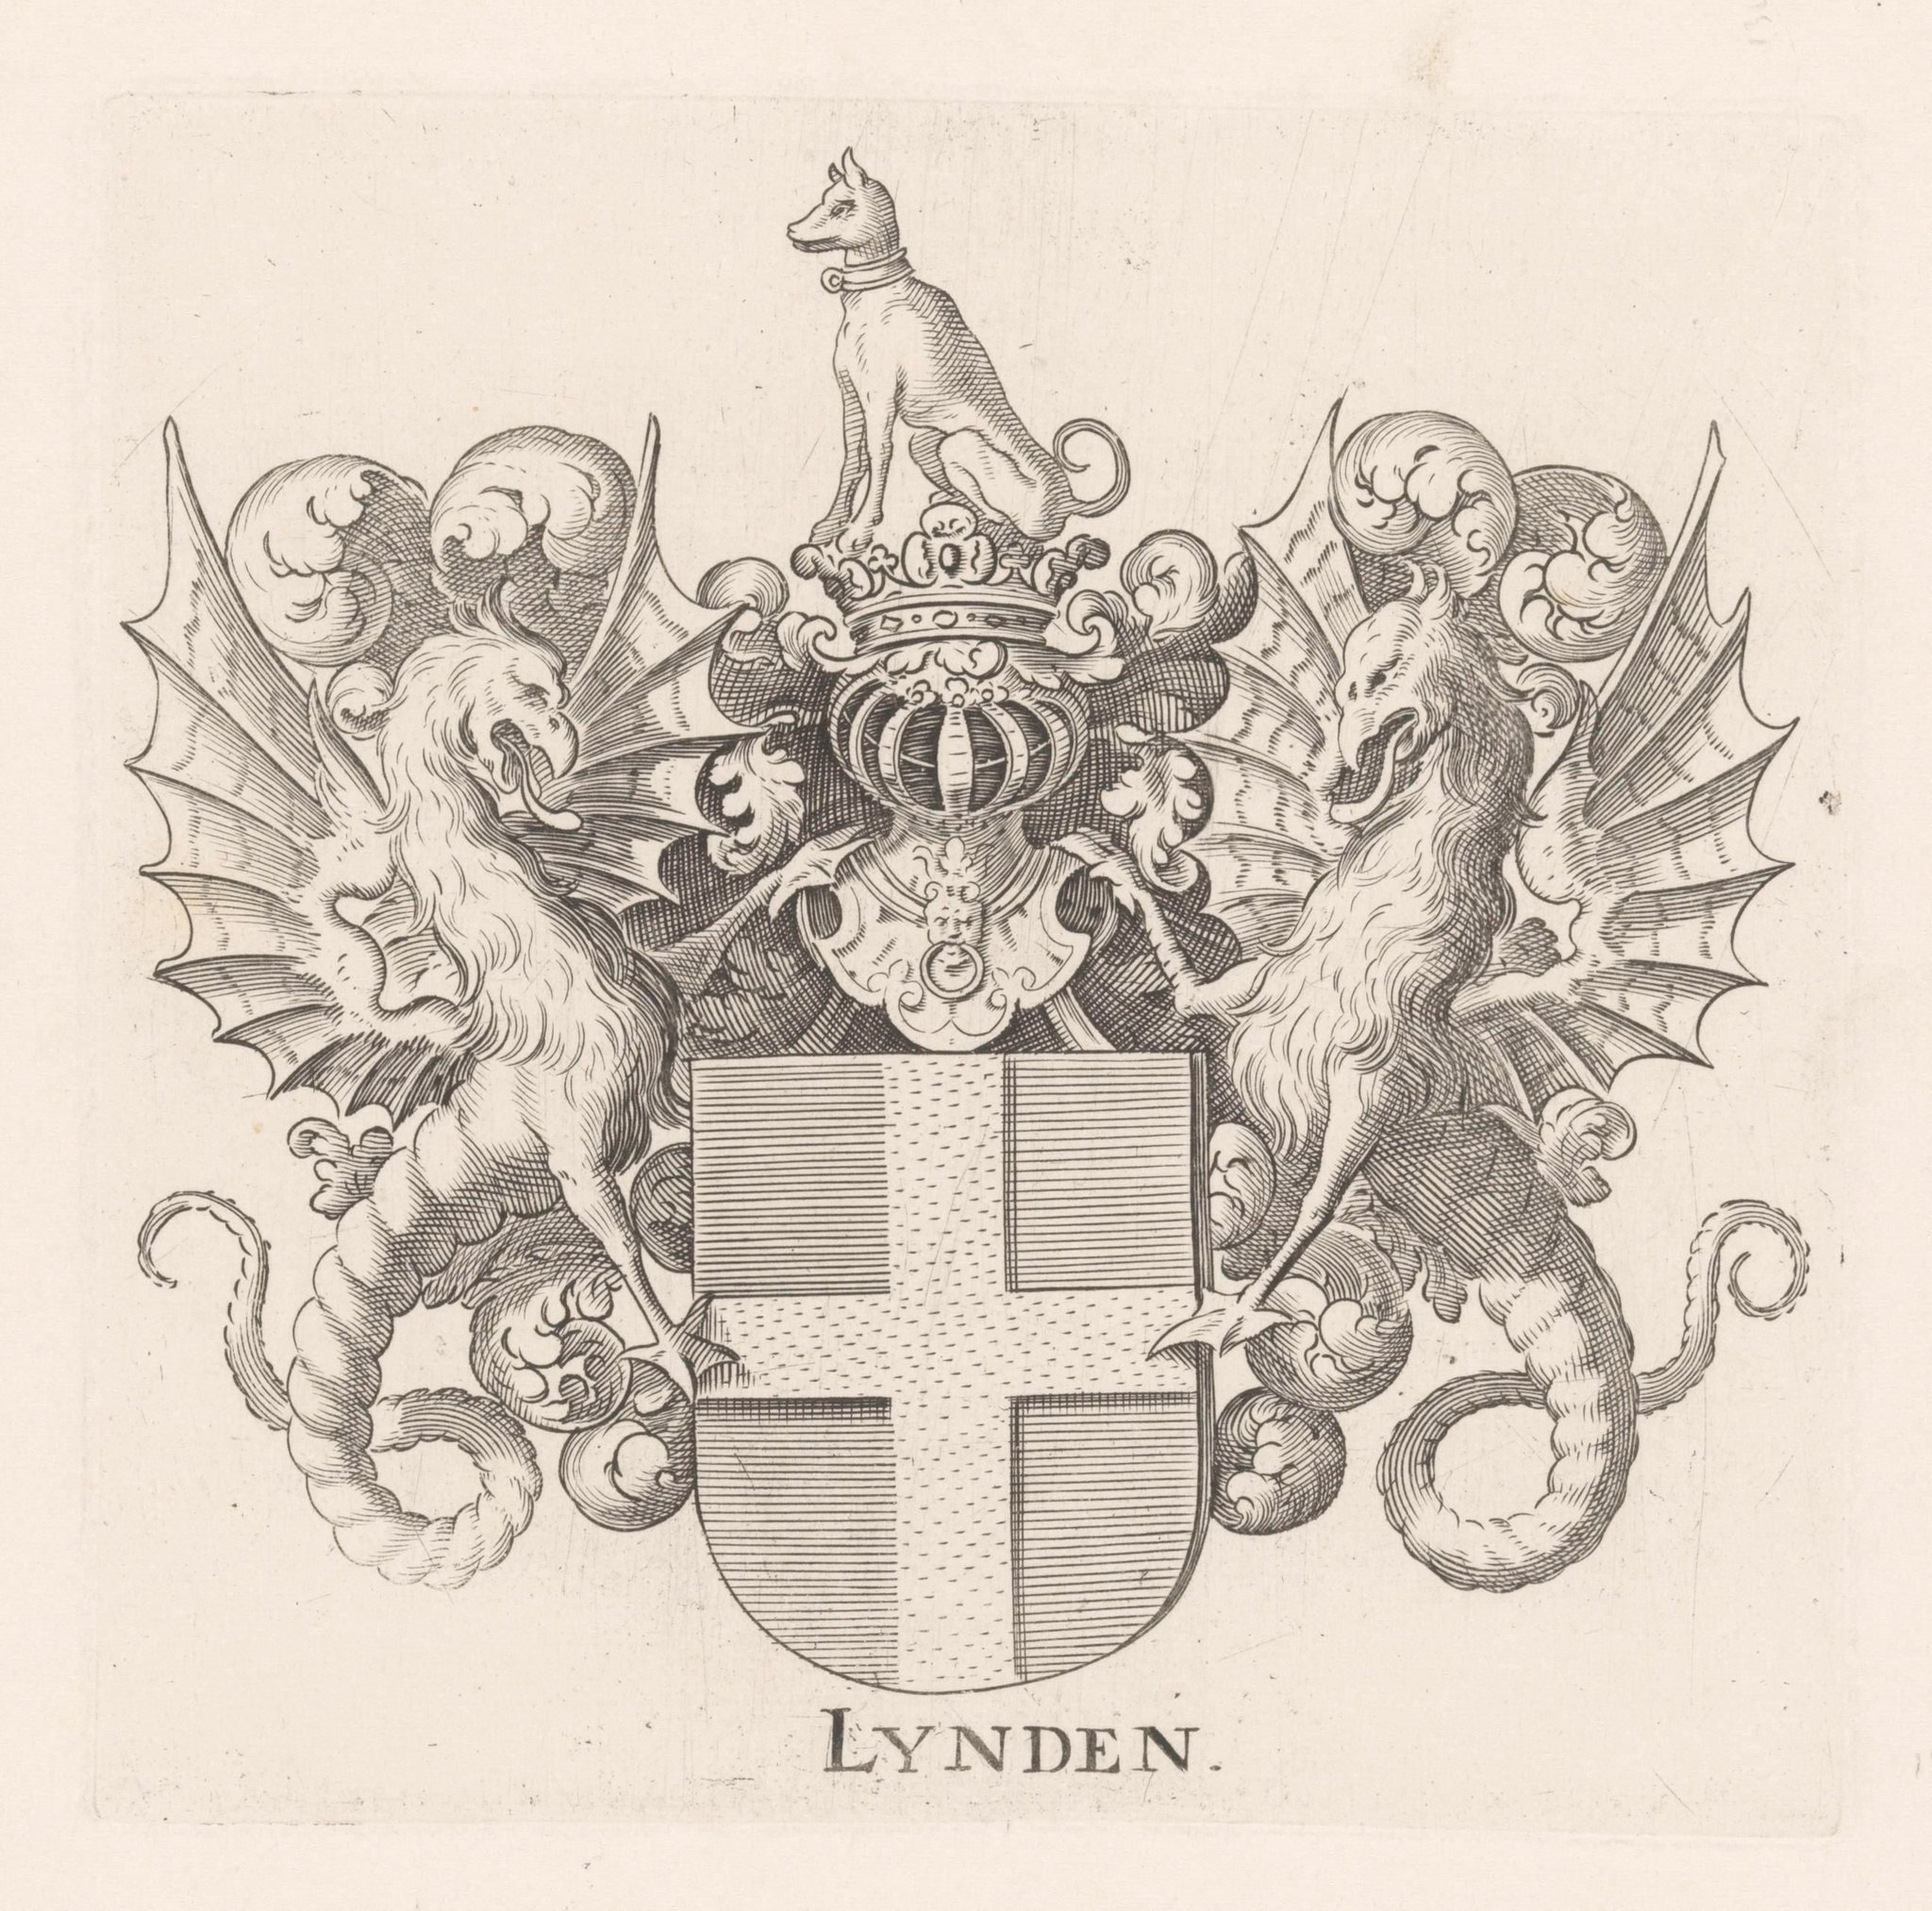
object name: print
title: Wapenschild van Van Lynden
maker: Anonymous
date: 1600-1800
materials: paper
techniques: etching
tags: armorial bearing, heraldry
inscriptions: collector's mark: Lugt 2228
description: Wapenschild van het geslacht van Lynden met griffioenen als schildhouders en een helmteken met hazenwindhond.